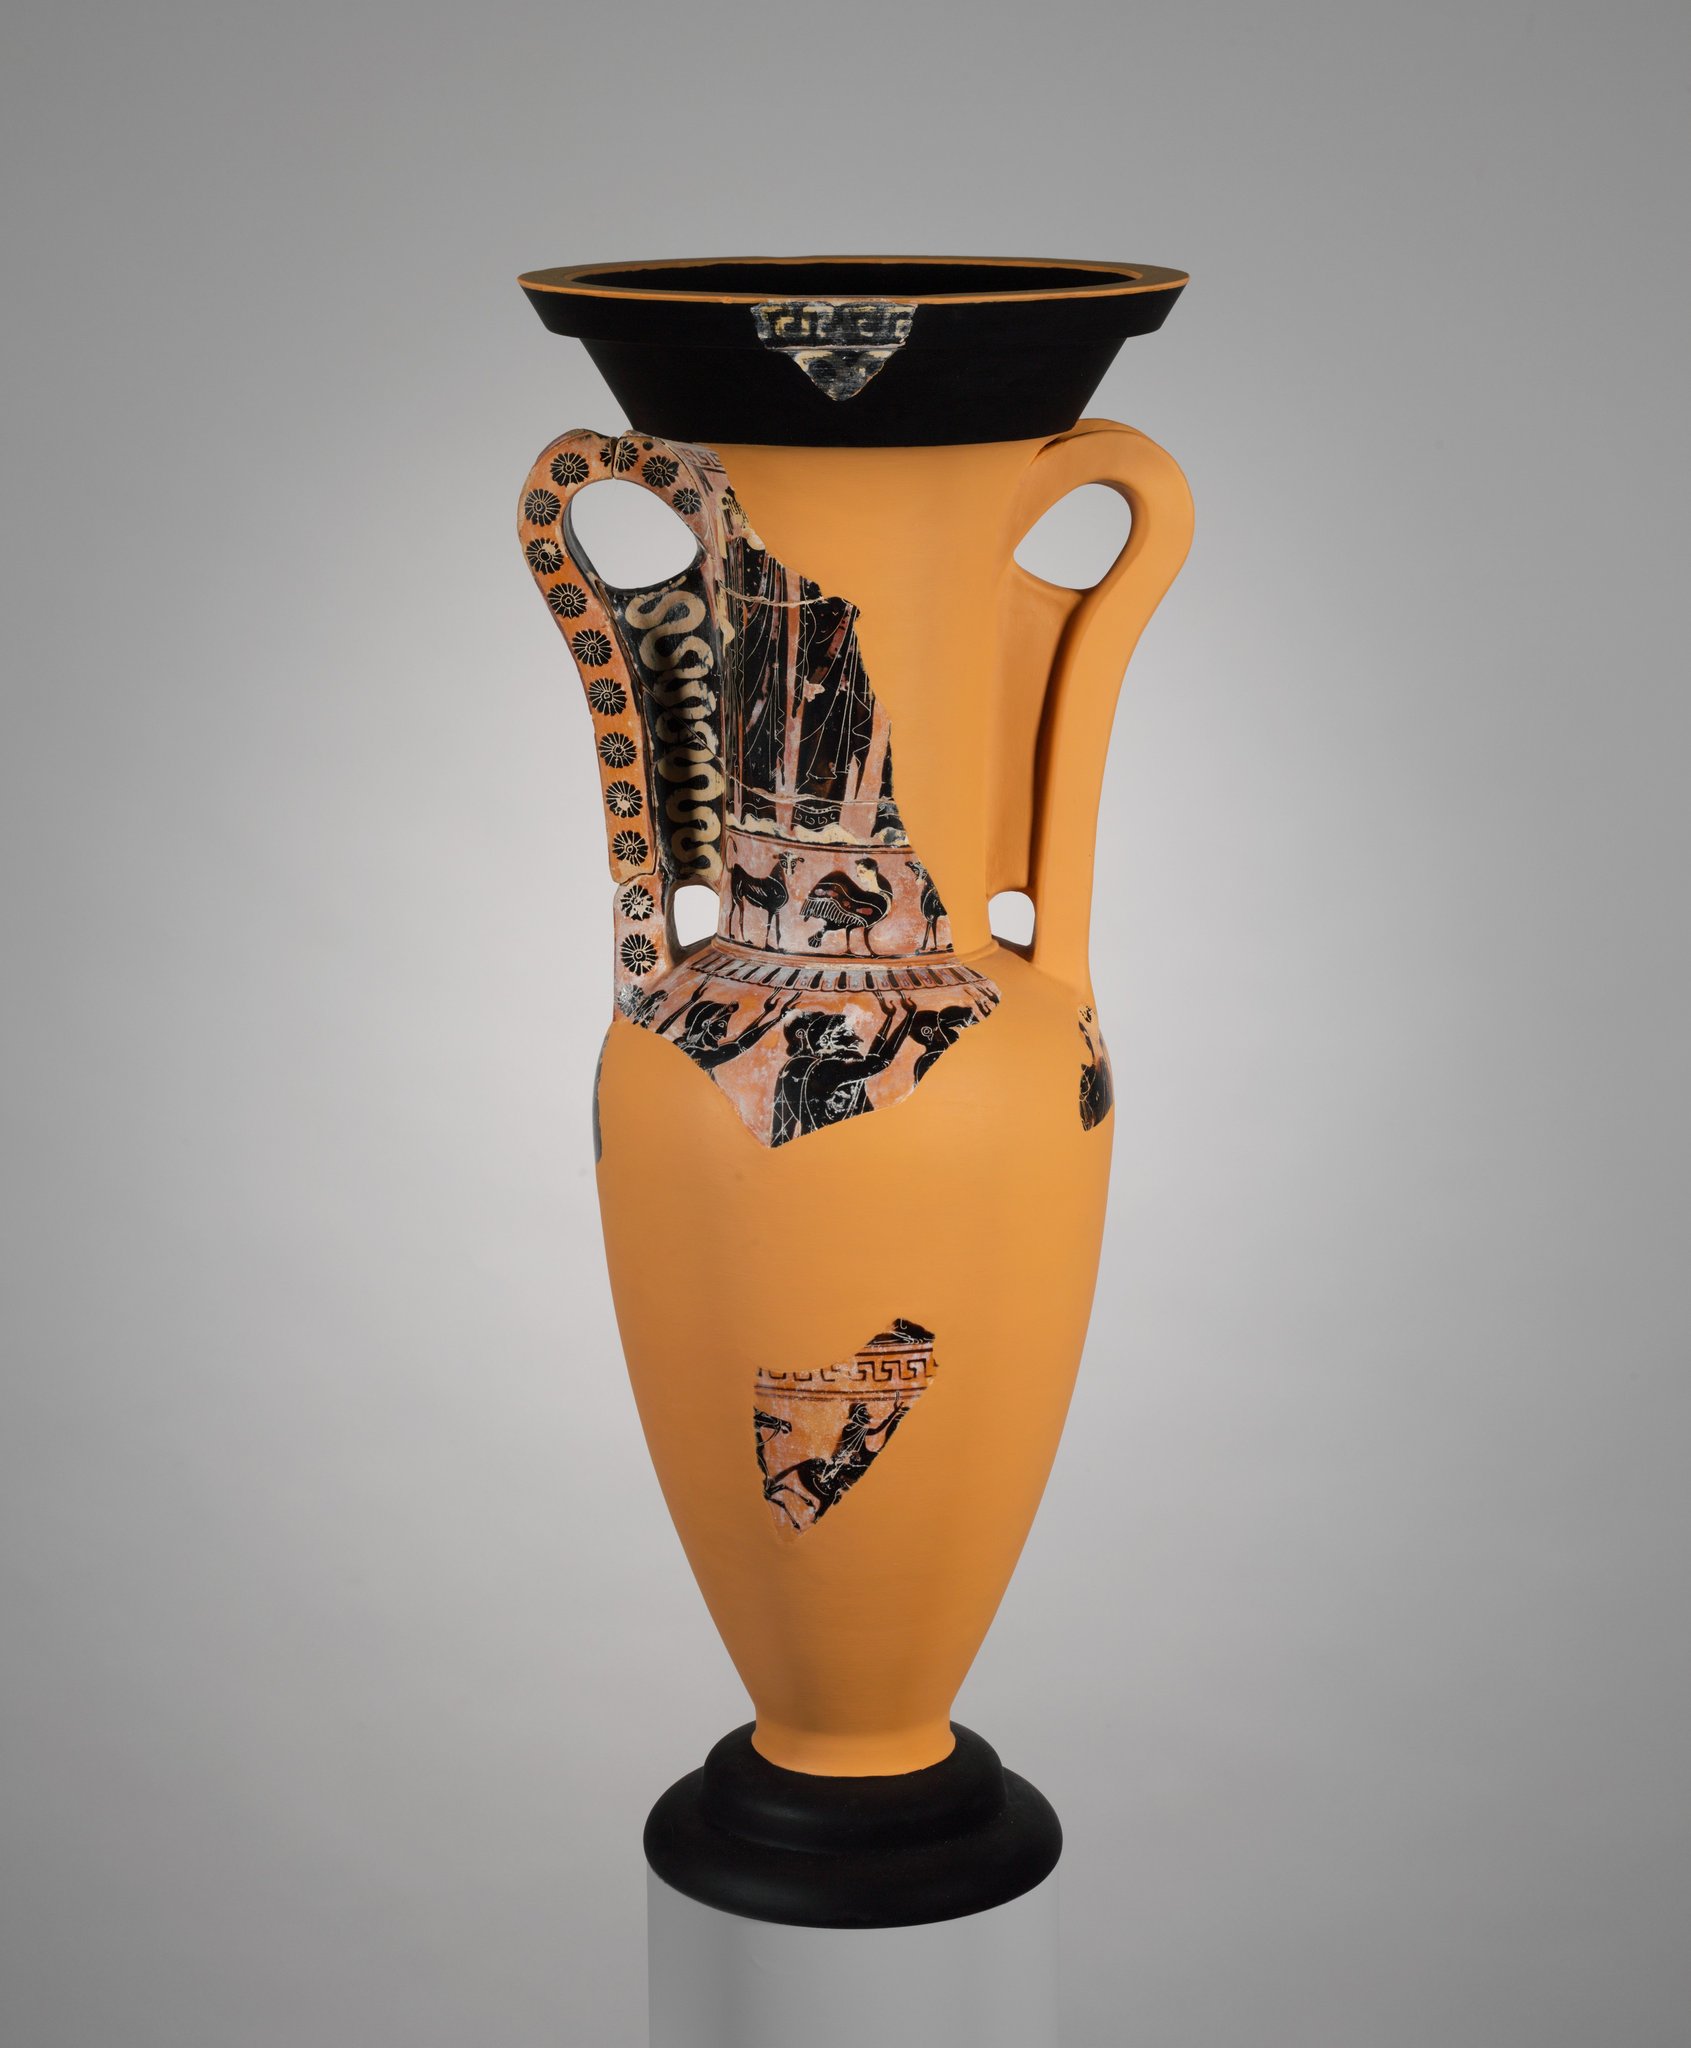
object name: loutrophoros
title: Terracotta loutrophoros (ceremonial vase for water)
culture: greek, attic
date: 525-501 BCE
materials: terracotta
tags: animals,men